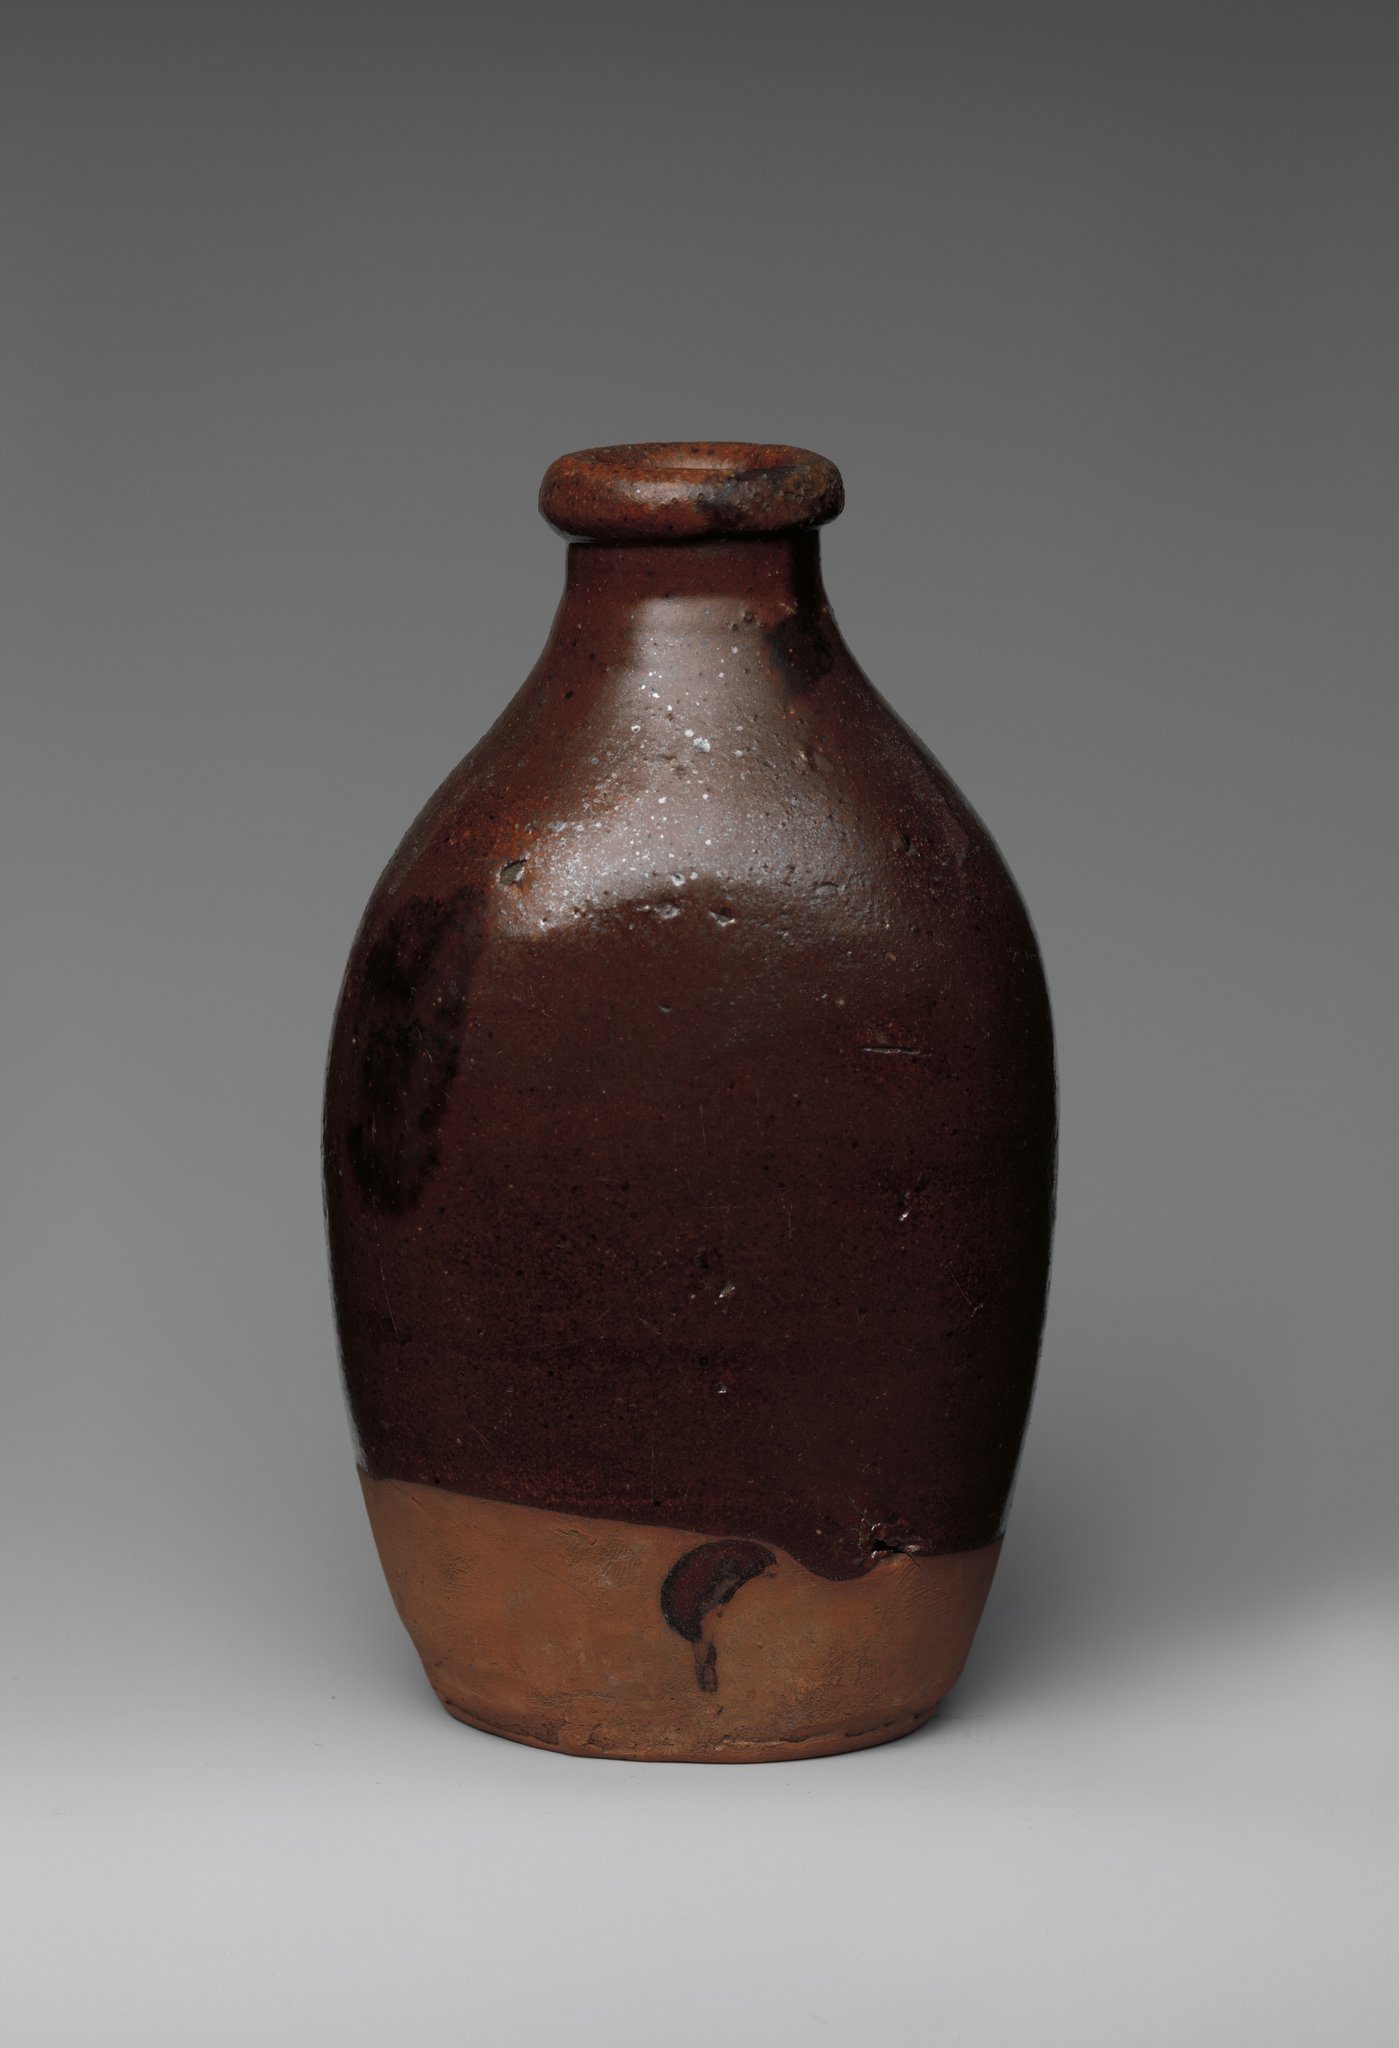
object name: bottle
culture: american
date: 1770-1830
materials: earthenware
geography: united states